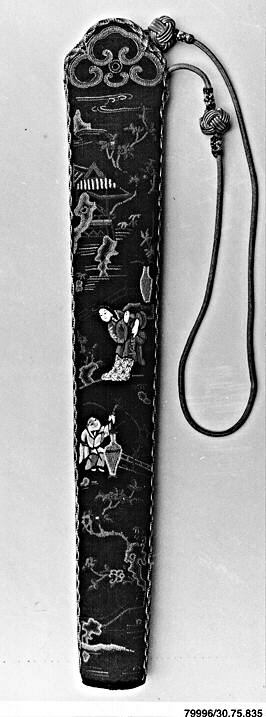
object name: fan holder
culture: chinese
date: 1701-1900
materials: silk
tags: human figures